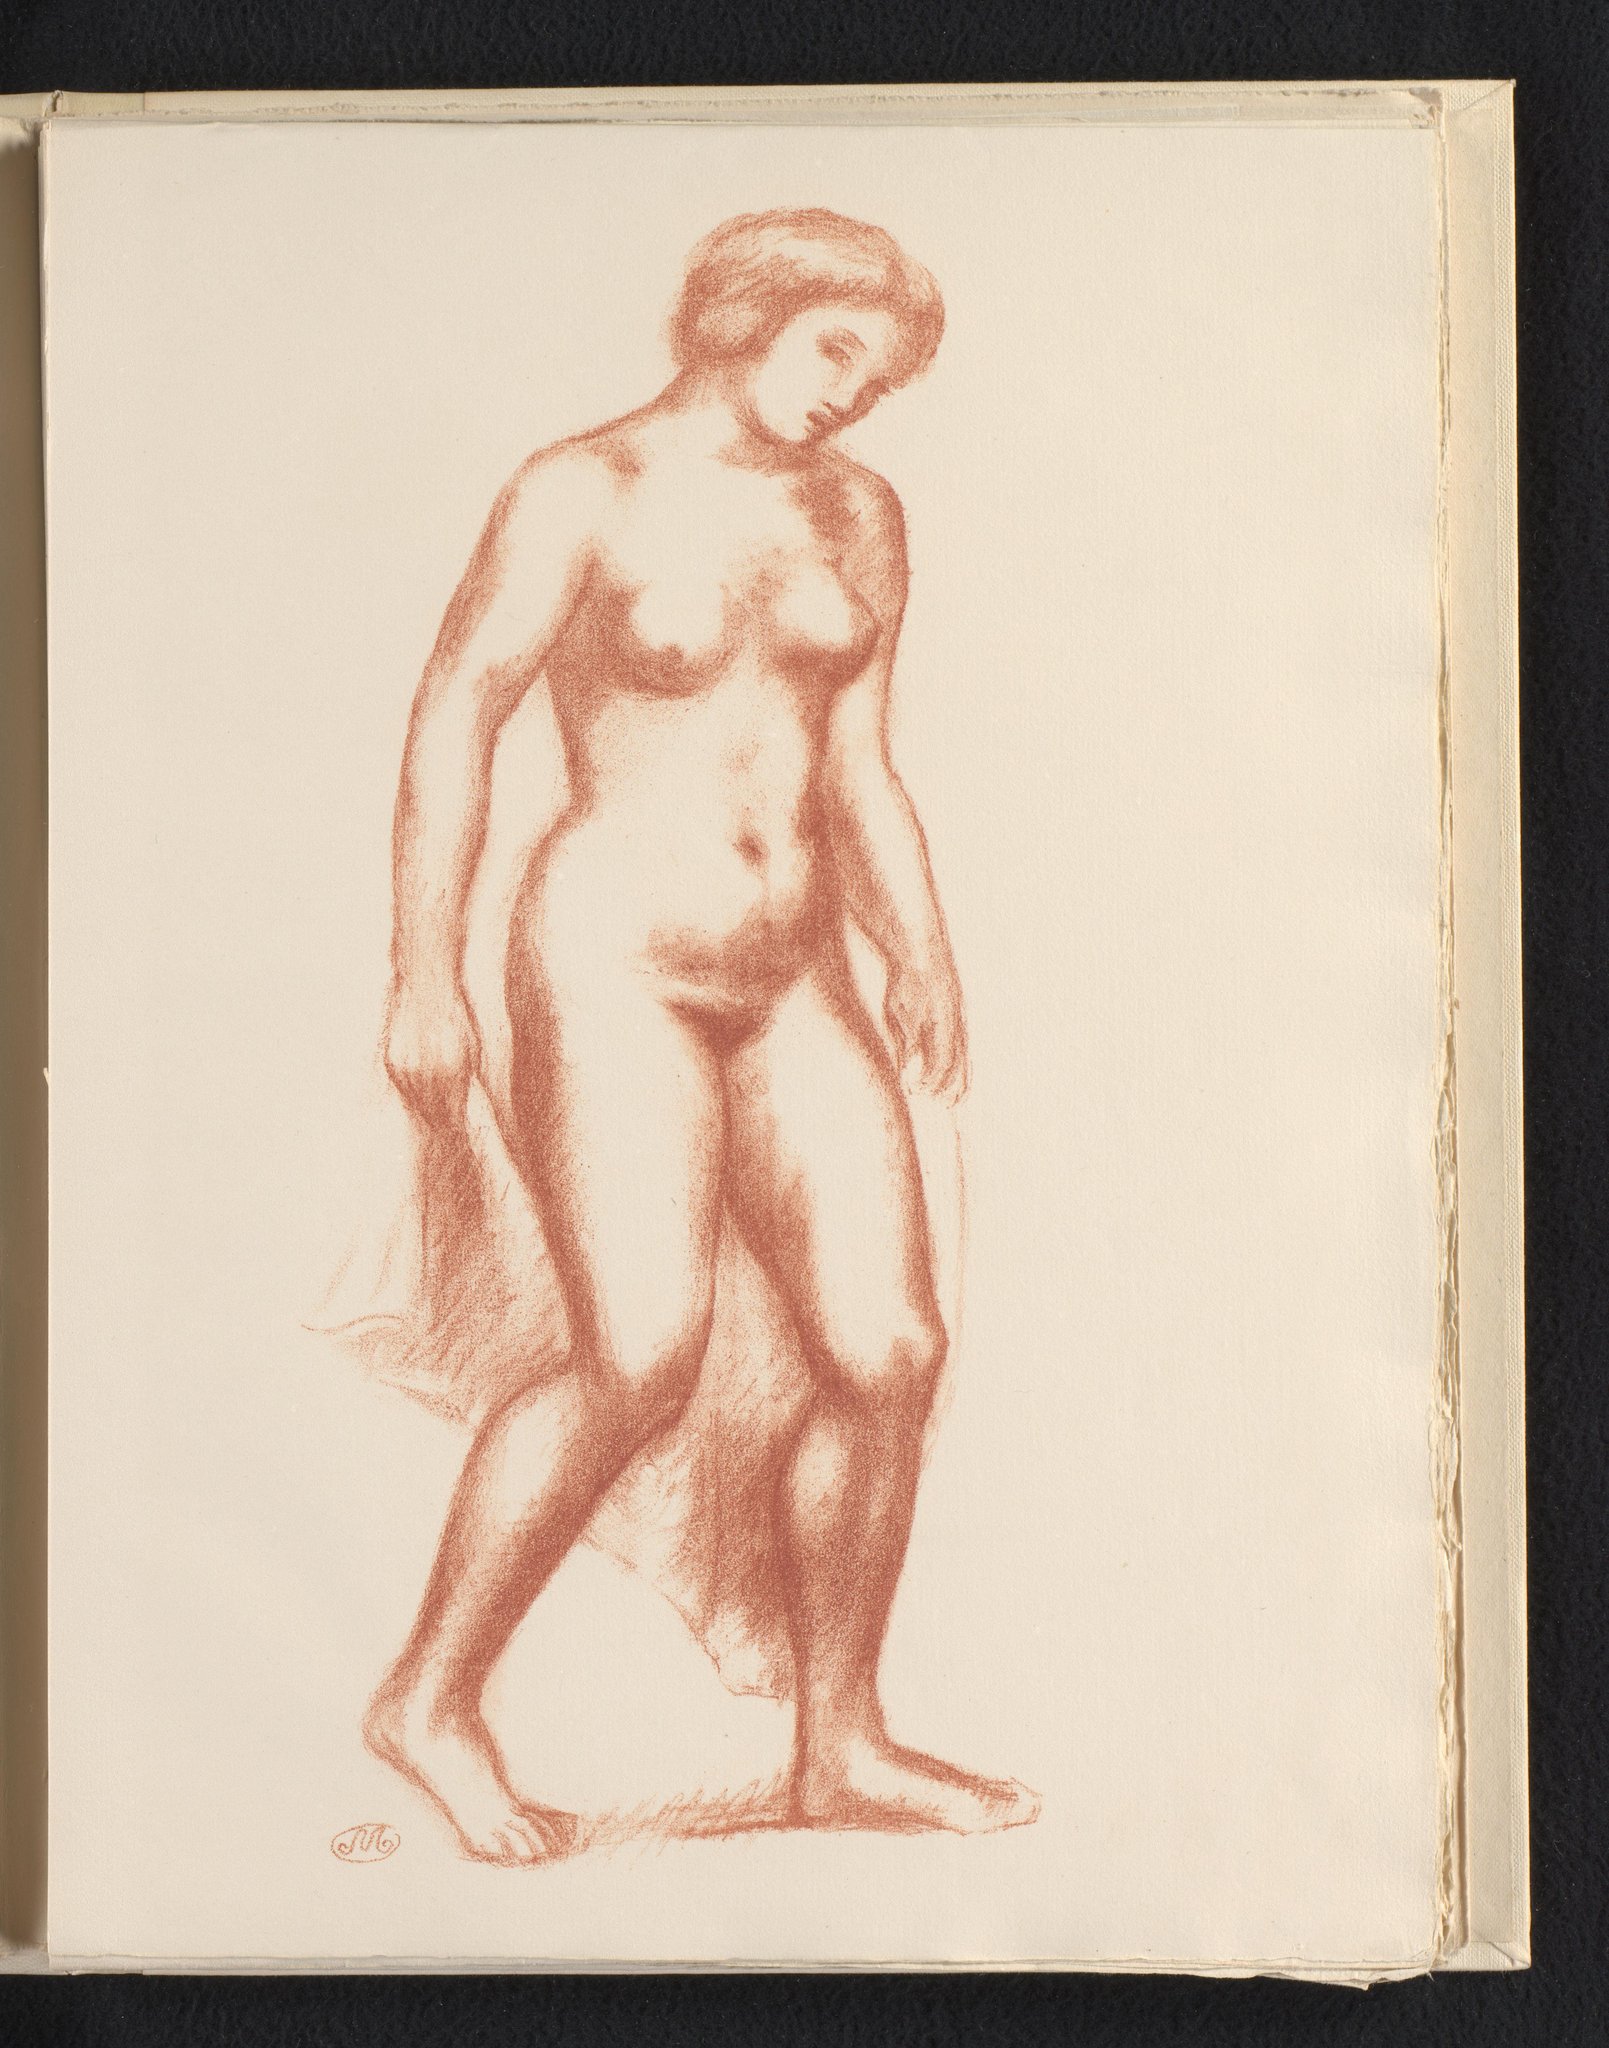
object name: book illustration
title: Staande naakte vrouw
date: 1948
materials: paper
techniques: lithograph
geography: paris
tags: woman (showing herself) undressed, quasi-nude, standing figure - aa - female human figure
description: Prent uit: Lucianus van Samosata. Dialogues des Courtisanes. [Vertaald uit het Grieks door] Charles Astruc. Parijs: s.n., 1948, deel van de suite met een extra afdruk van de prenten in sanguine.